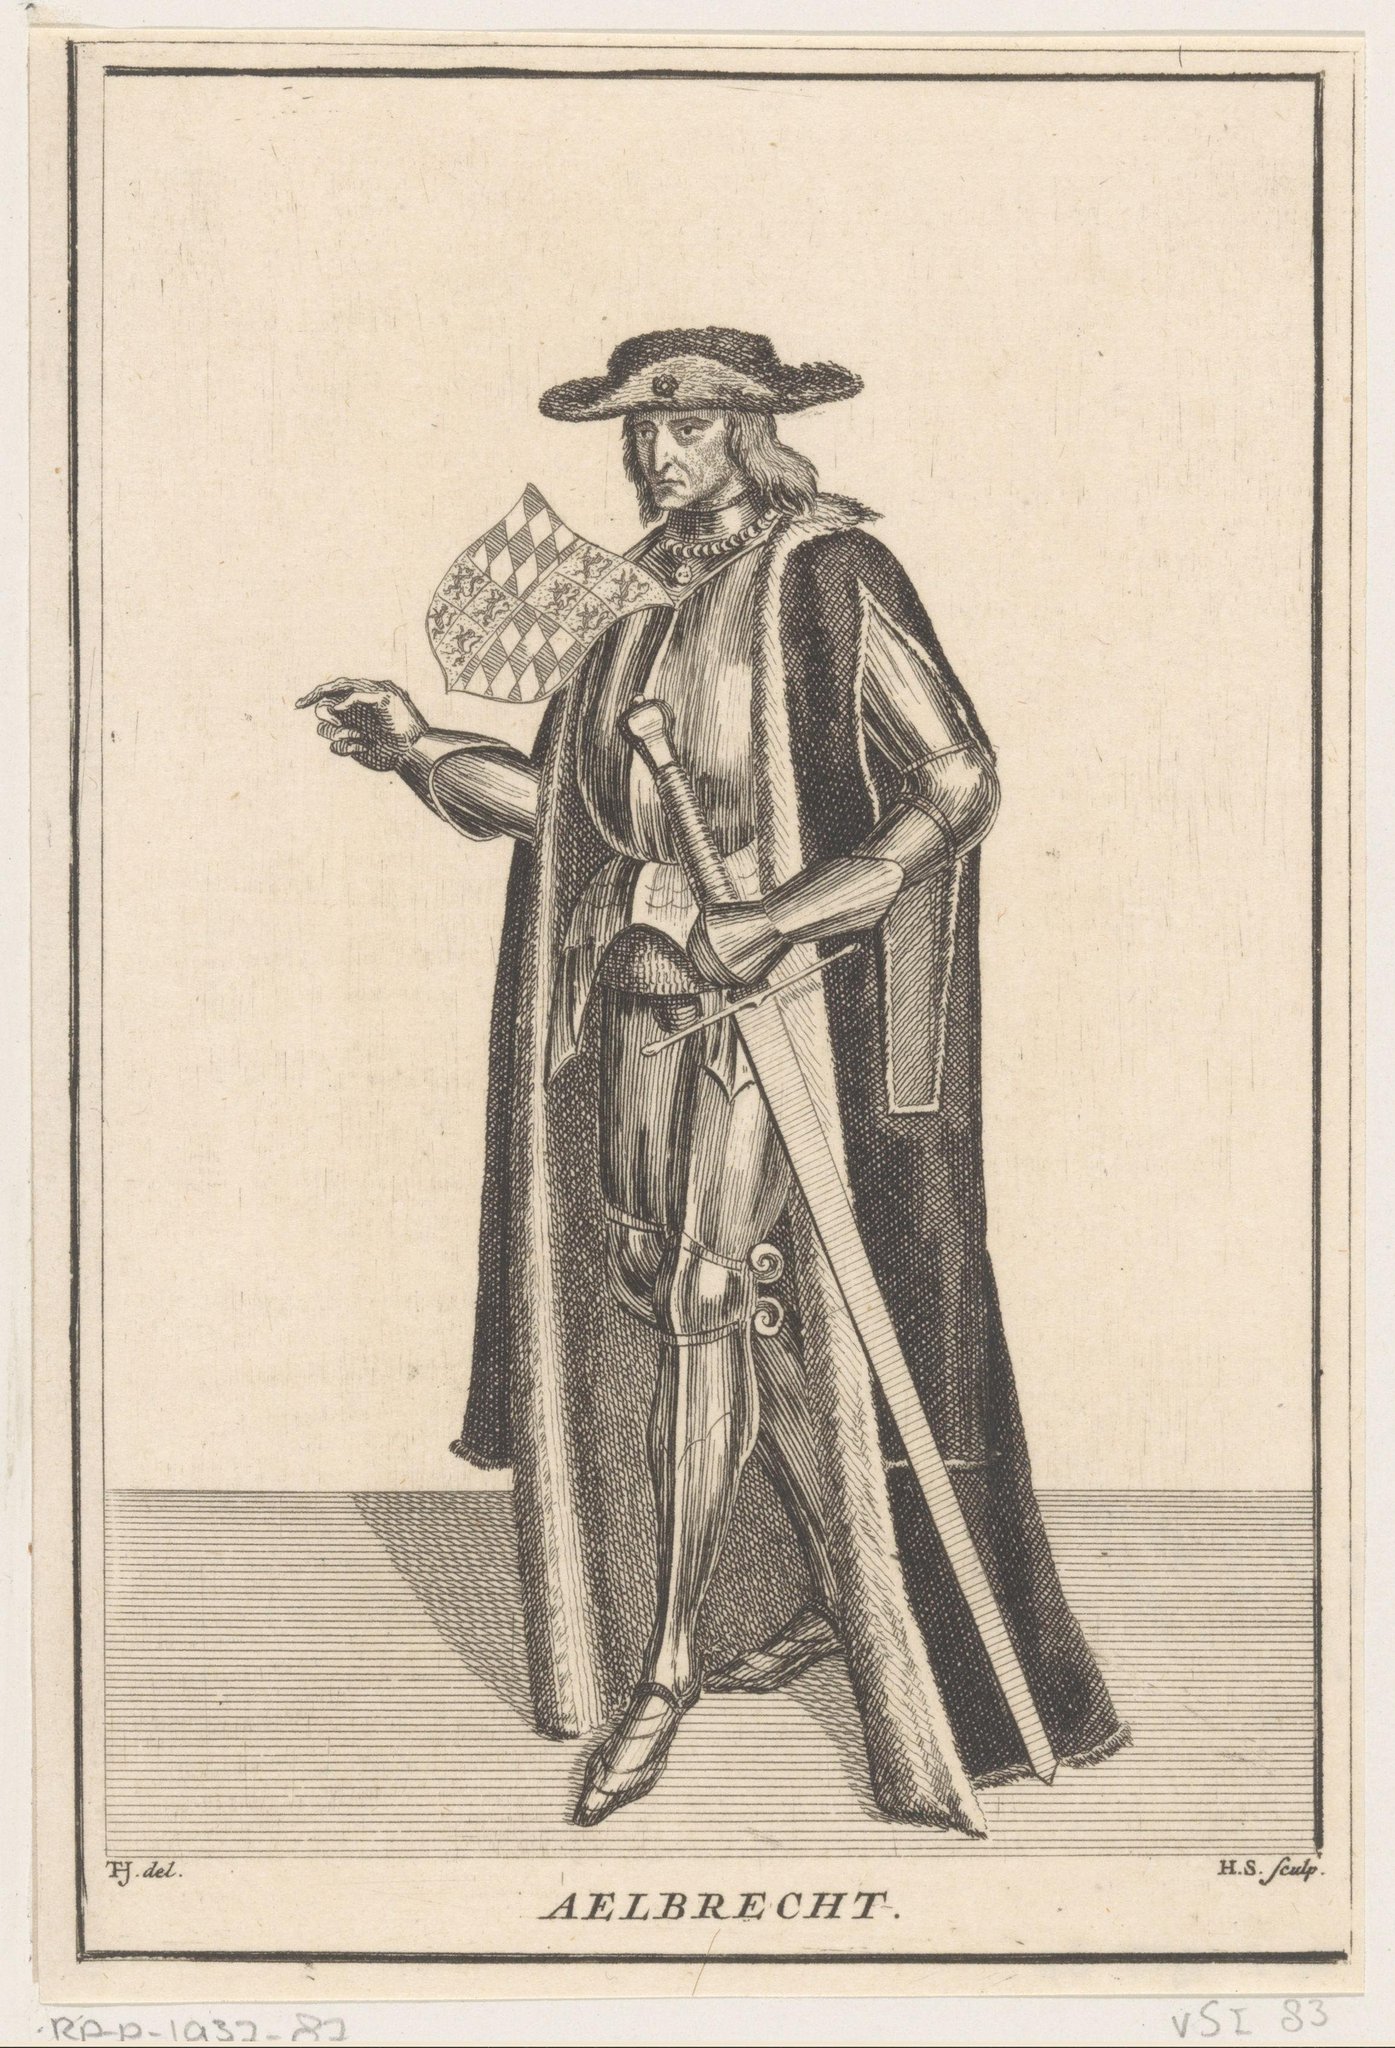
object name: book illustration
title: Portret van Albrecht van Beieren, graaf van Holland, Henegouwen en Zeeland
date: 1745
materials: paper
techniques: etching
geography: haarlem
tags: the hague, duke of bavaria albert i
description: Portret van Albrecht van Beieren in een rechthoekige omlijsting. Linksboven zijn wapen. In de ondermarge zijn naam.